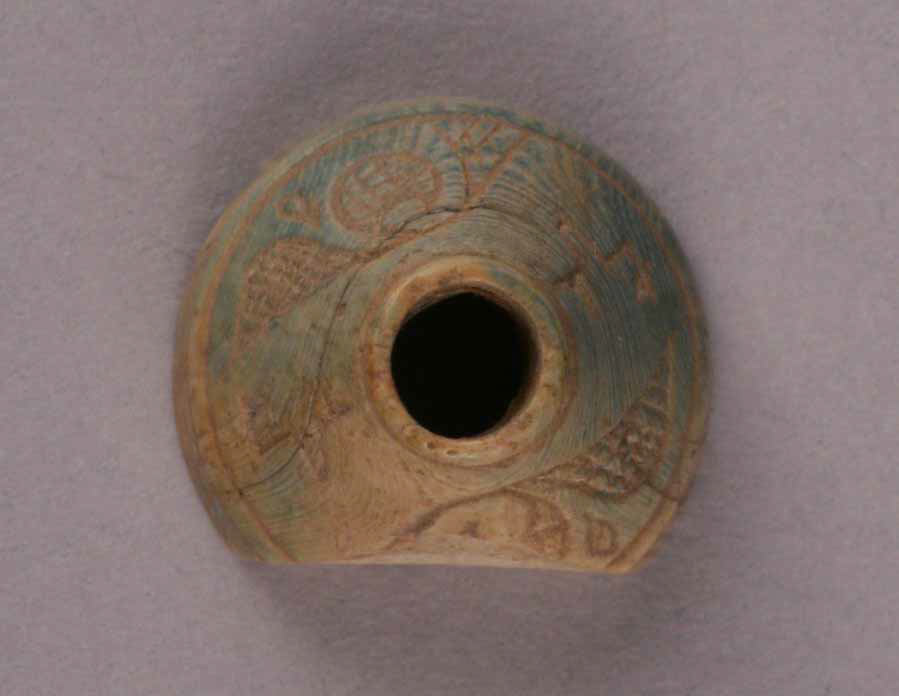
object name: spindle whorl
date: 801-1000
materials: bone, paint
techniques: incising, inlay, tinting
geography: iran